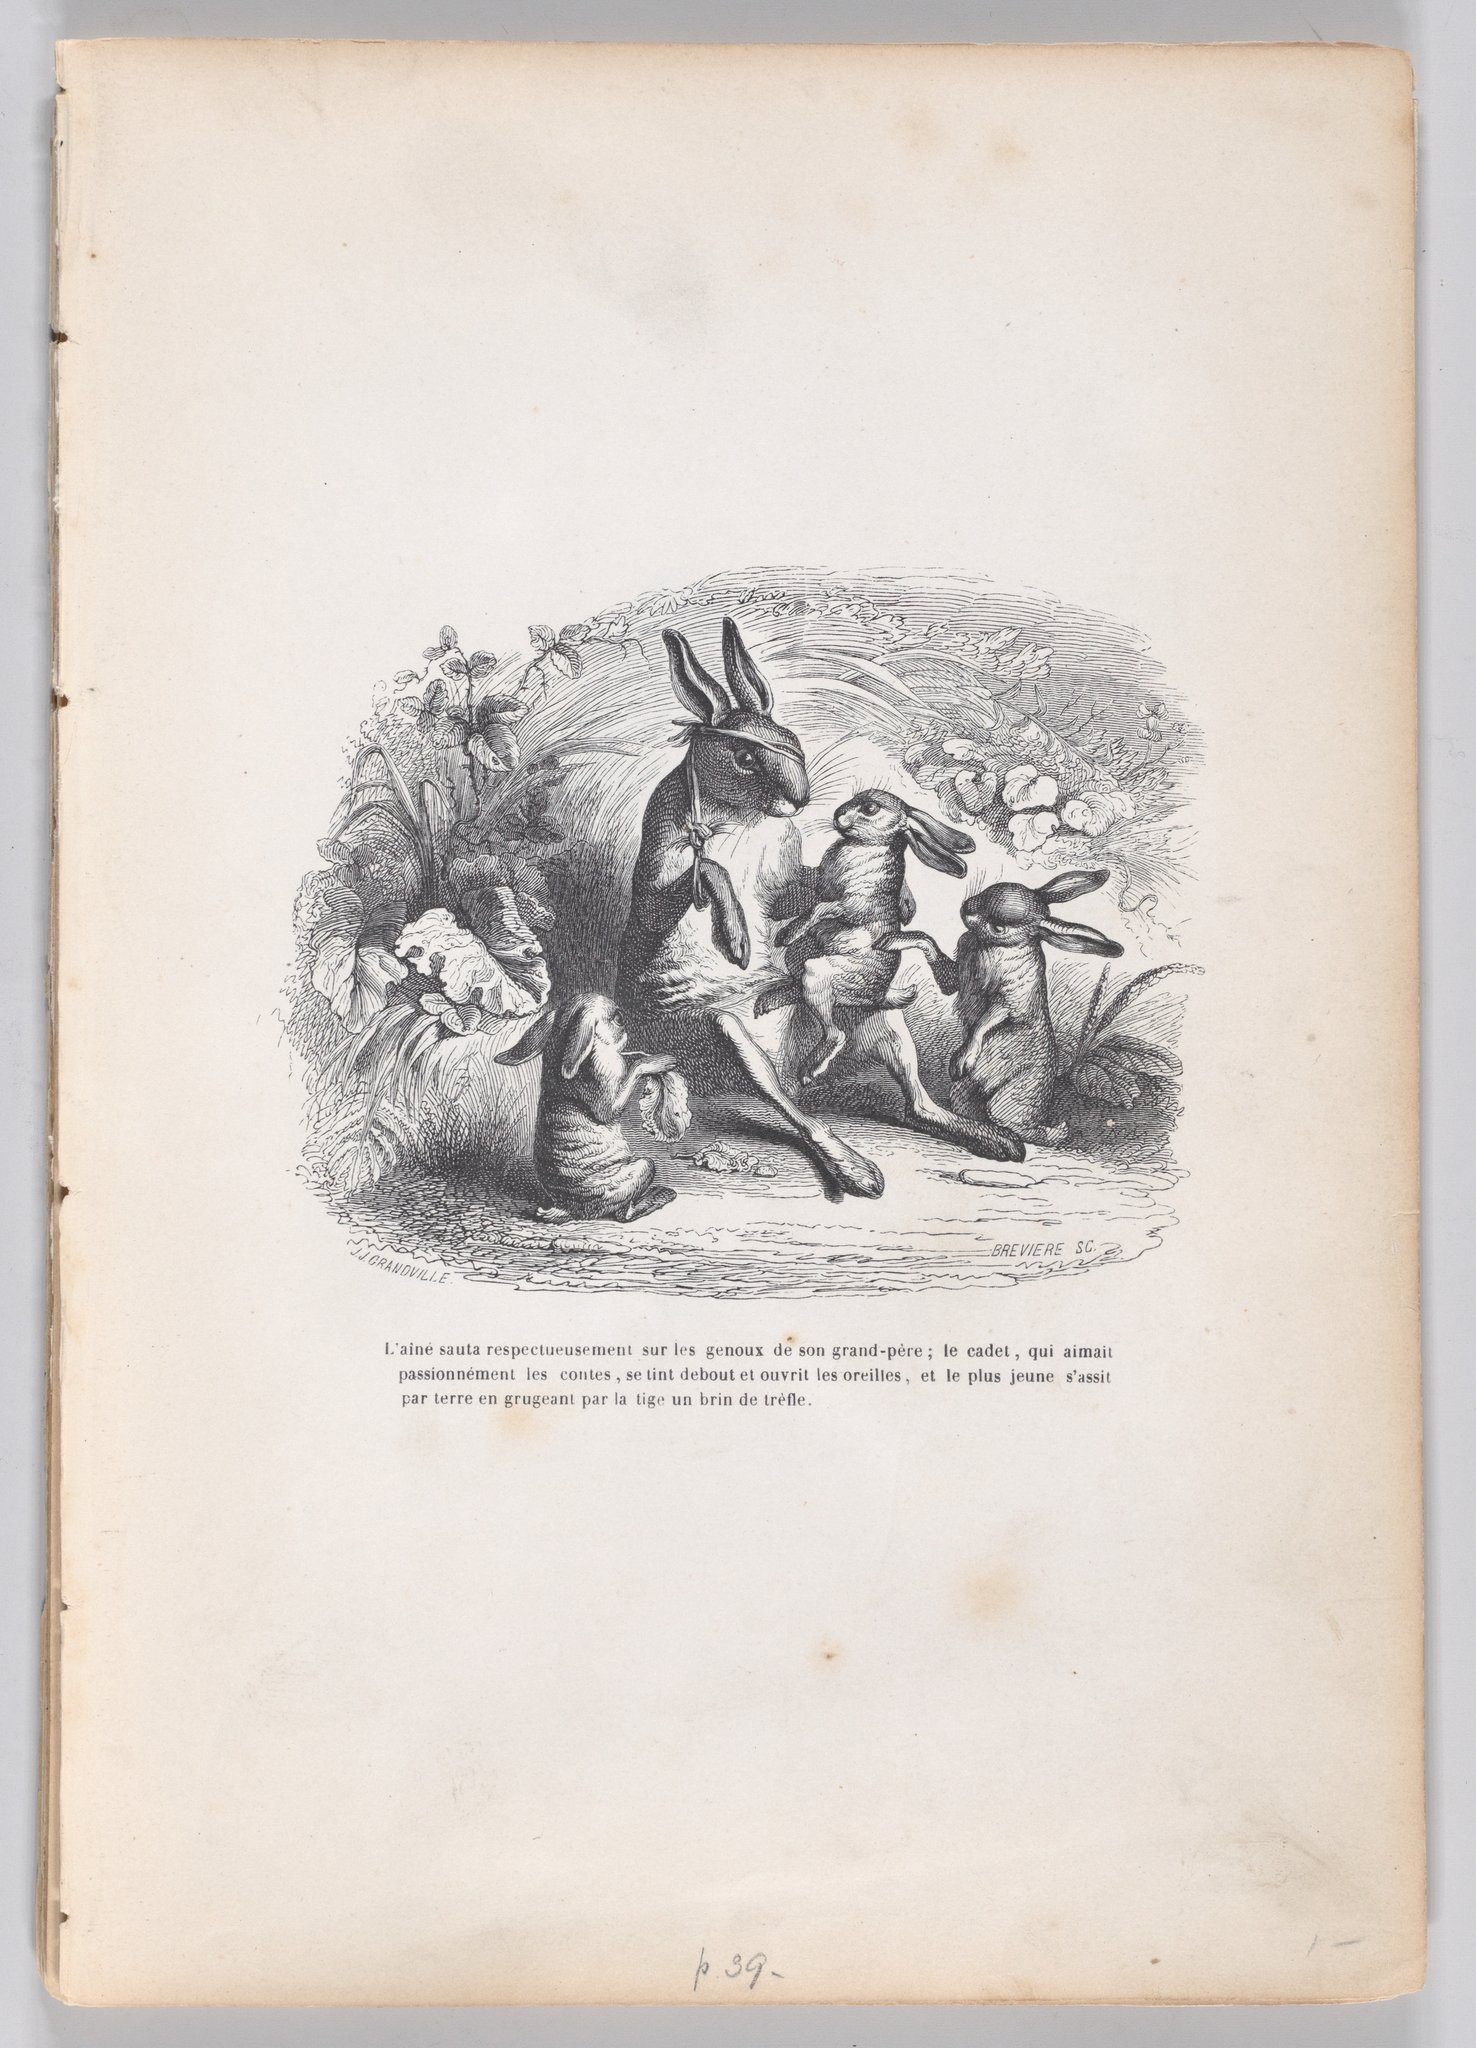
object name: print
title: The oldest rabbit jumped respectfully on his grandfather's lap..., from "Scenes from the Private and Public Life of Animals"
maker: j. j. grandville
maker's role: illustrator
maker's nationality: french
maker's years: 1803-1847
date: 1837-1847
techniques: engraving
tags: rabbits